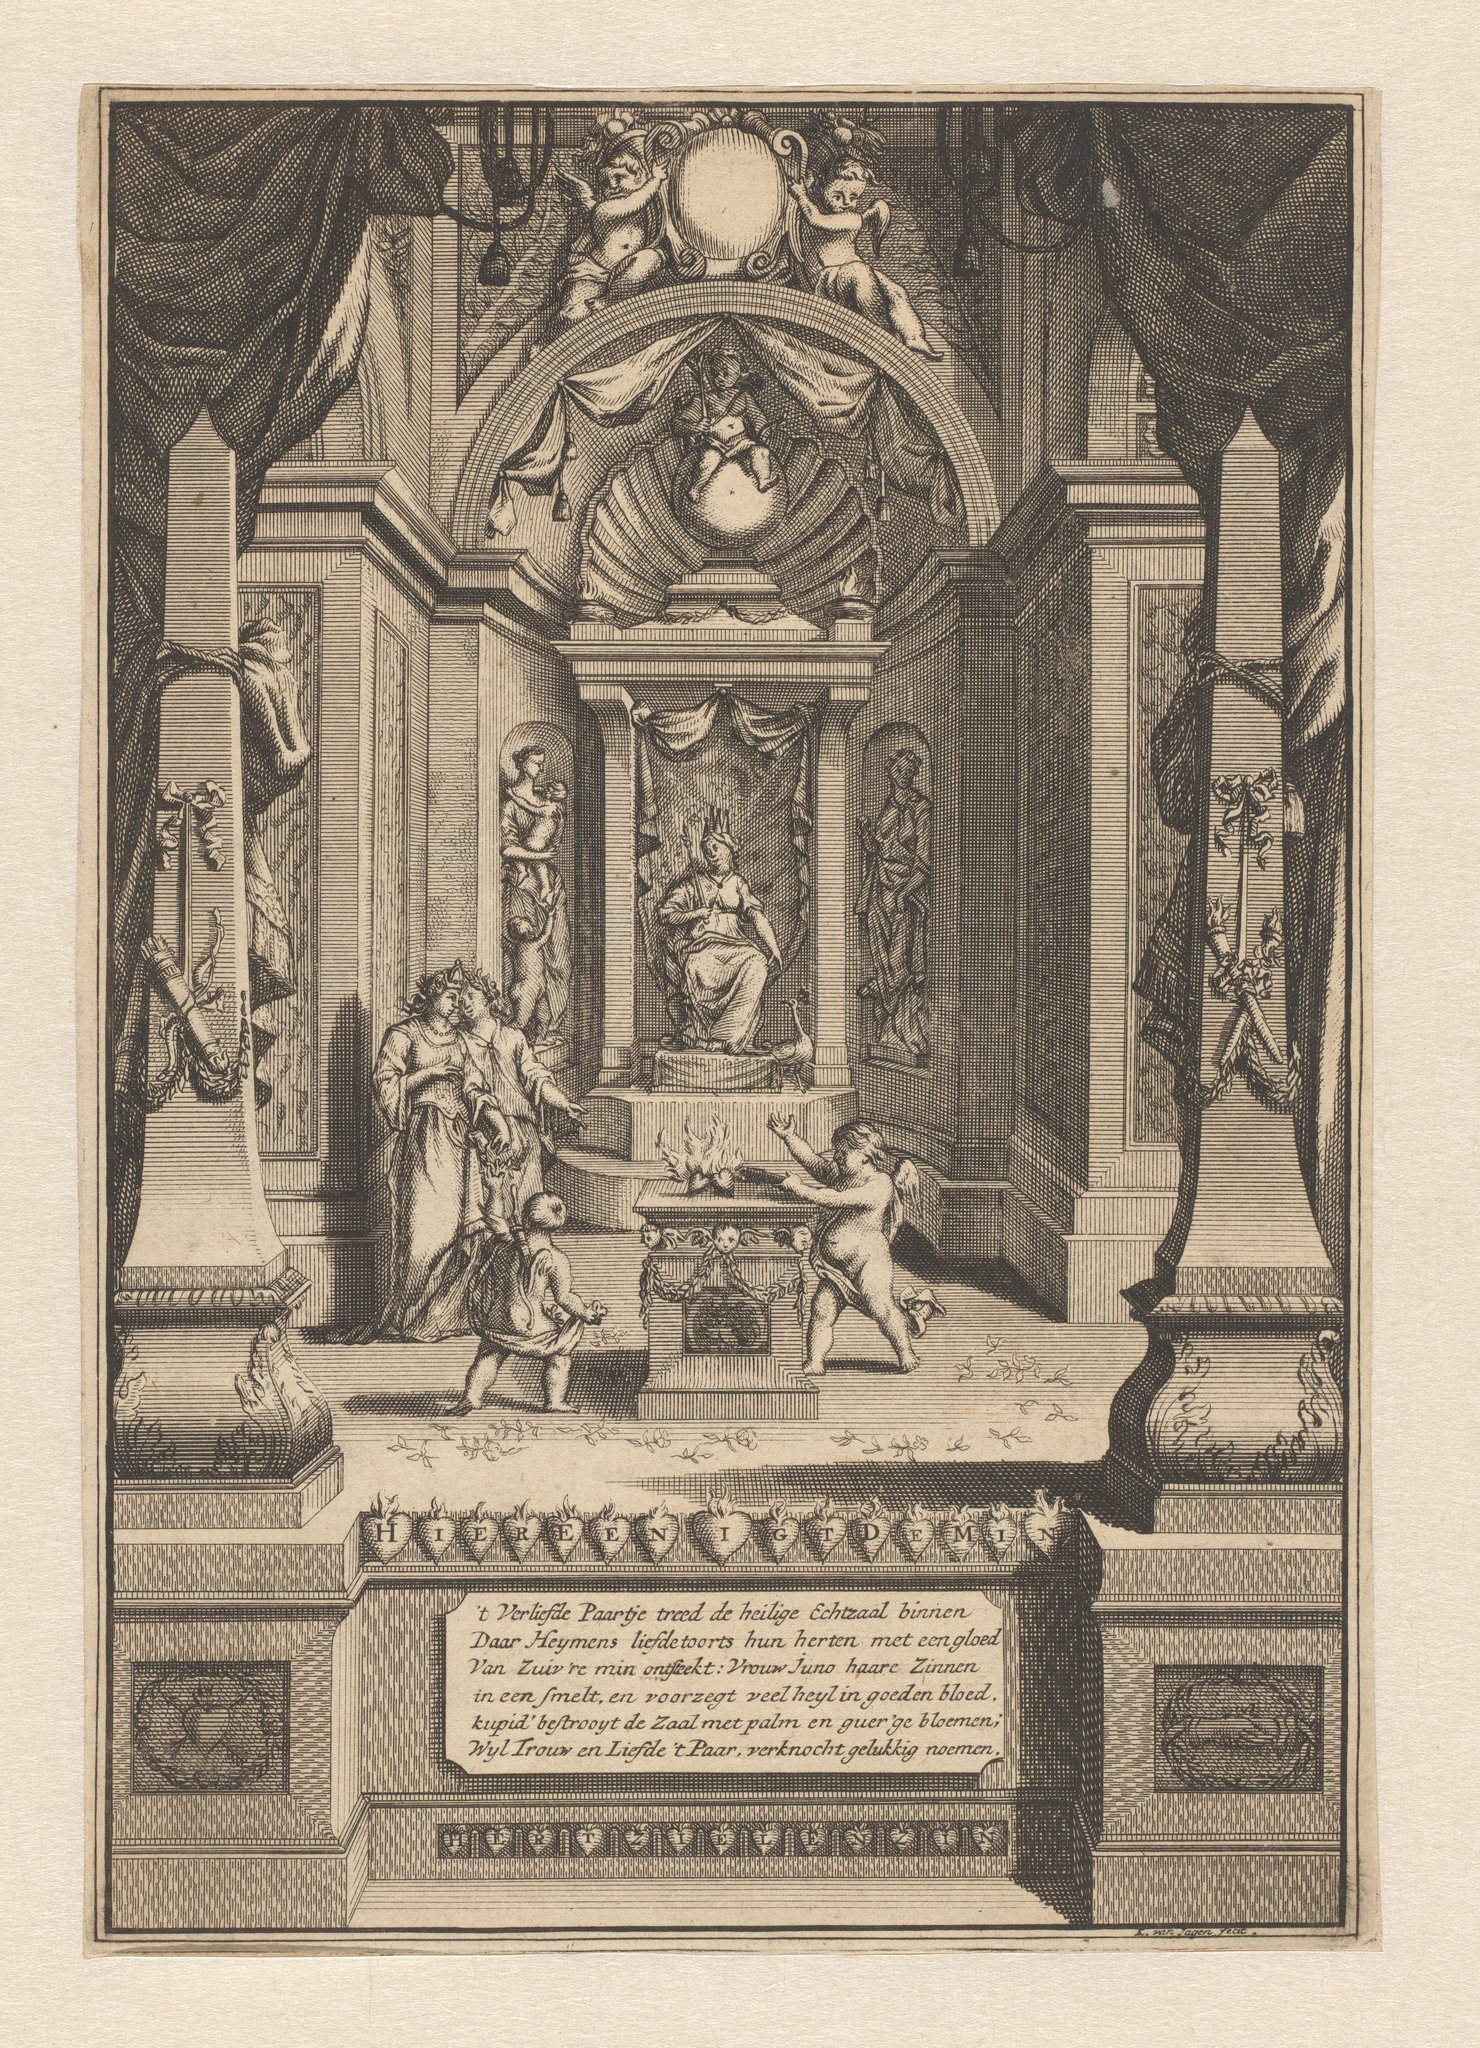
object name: print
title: Huwelijksprent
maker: cornelis van jagen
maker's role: print maker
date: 1706-1744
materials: paper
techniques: engraving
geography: amsterdam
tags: specific aspects, allegorical aspects of juno; juno as patroness, charity, 'caritas'; 'carità' (ripa) ~ one of the three theological virtues, fidelity; 'fedeltà' (ripa), marriage, married couple, 'matrimonium', love personified, (story of) cupid, amor (eros)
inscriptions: collector's mark: Lugt 2760, collector's mark: Lugt 2228